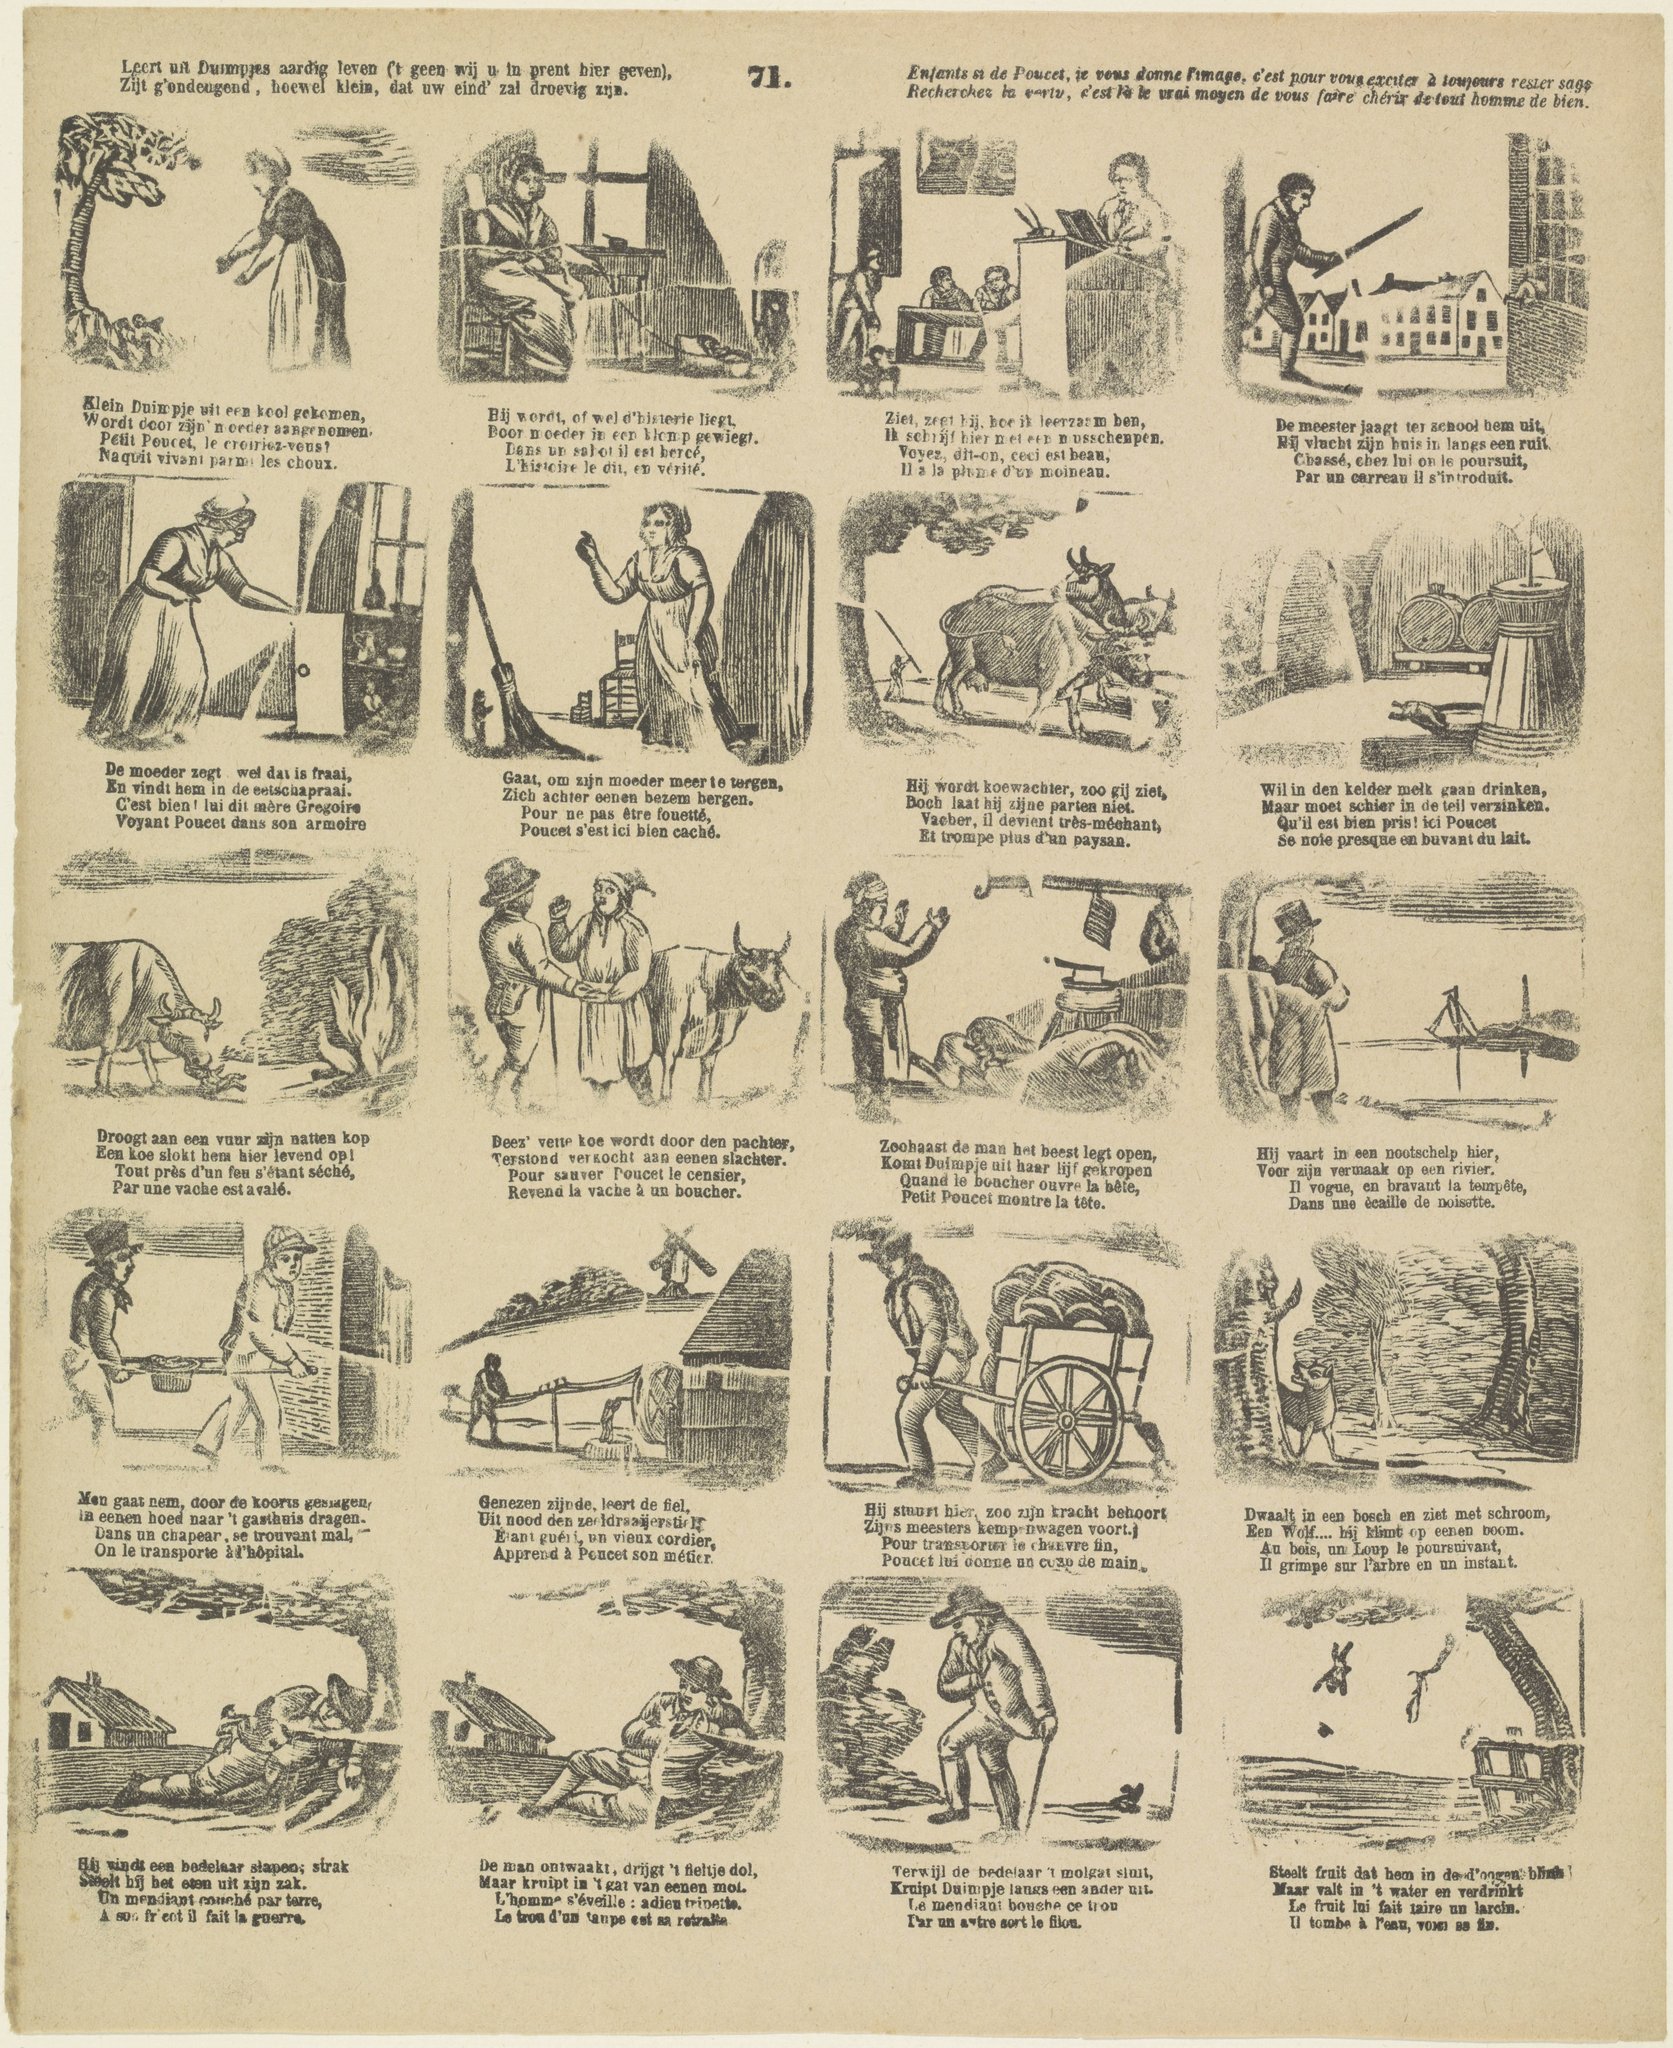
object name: print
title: Leert uit Duimpjes aardig leven, ('t geen wij u in prent hier geven : ) / Zijt g'ondeugend, hoewel klein, dat uw eind' zal droevig zijn / Enfants si de Poucet, je vous donne l'image, c'est pour vous exciter à toujours rester sage; / Recherchez la vertu, c'est là le vrai moyen de vous faire chérir de tout homme de bien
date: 1800-1833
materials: paper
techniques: colour, letterpress printing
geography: turnhout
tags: tales and fairy tales, tales and fairy tales: little thumbling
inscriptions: collector's mark: Lugt 2760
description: Blad met 20 voorstellingen uit het verhaal van Klein Duimpje. Onder elke voorstelling een tweeregelig vers in het Nederlands en in het Frans. Genummerd midden boven: 71.